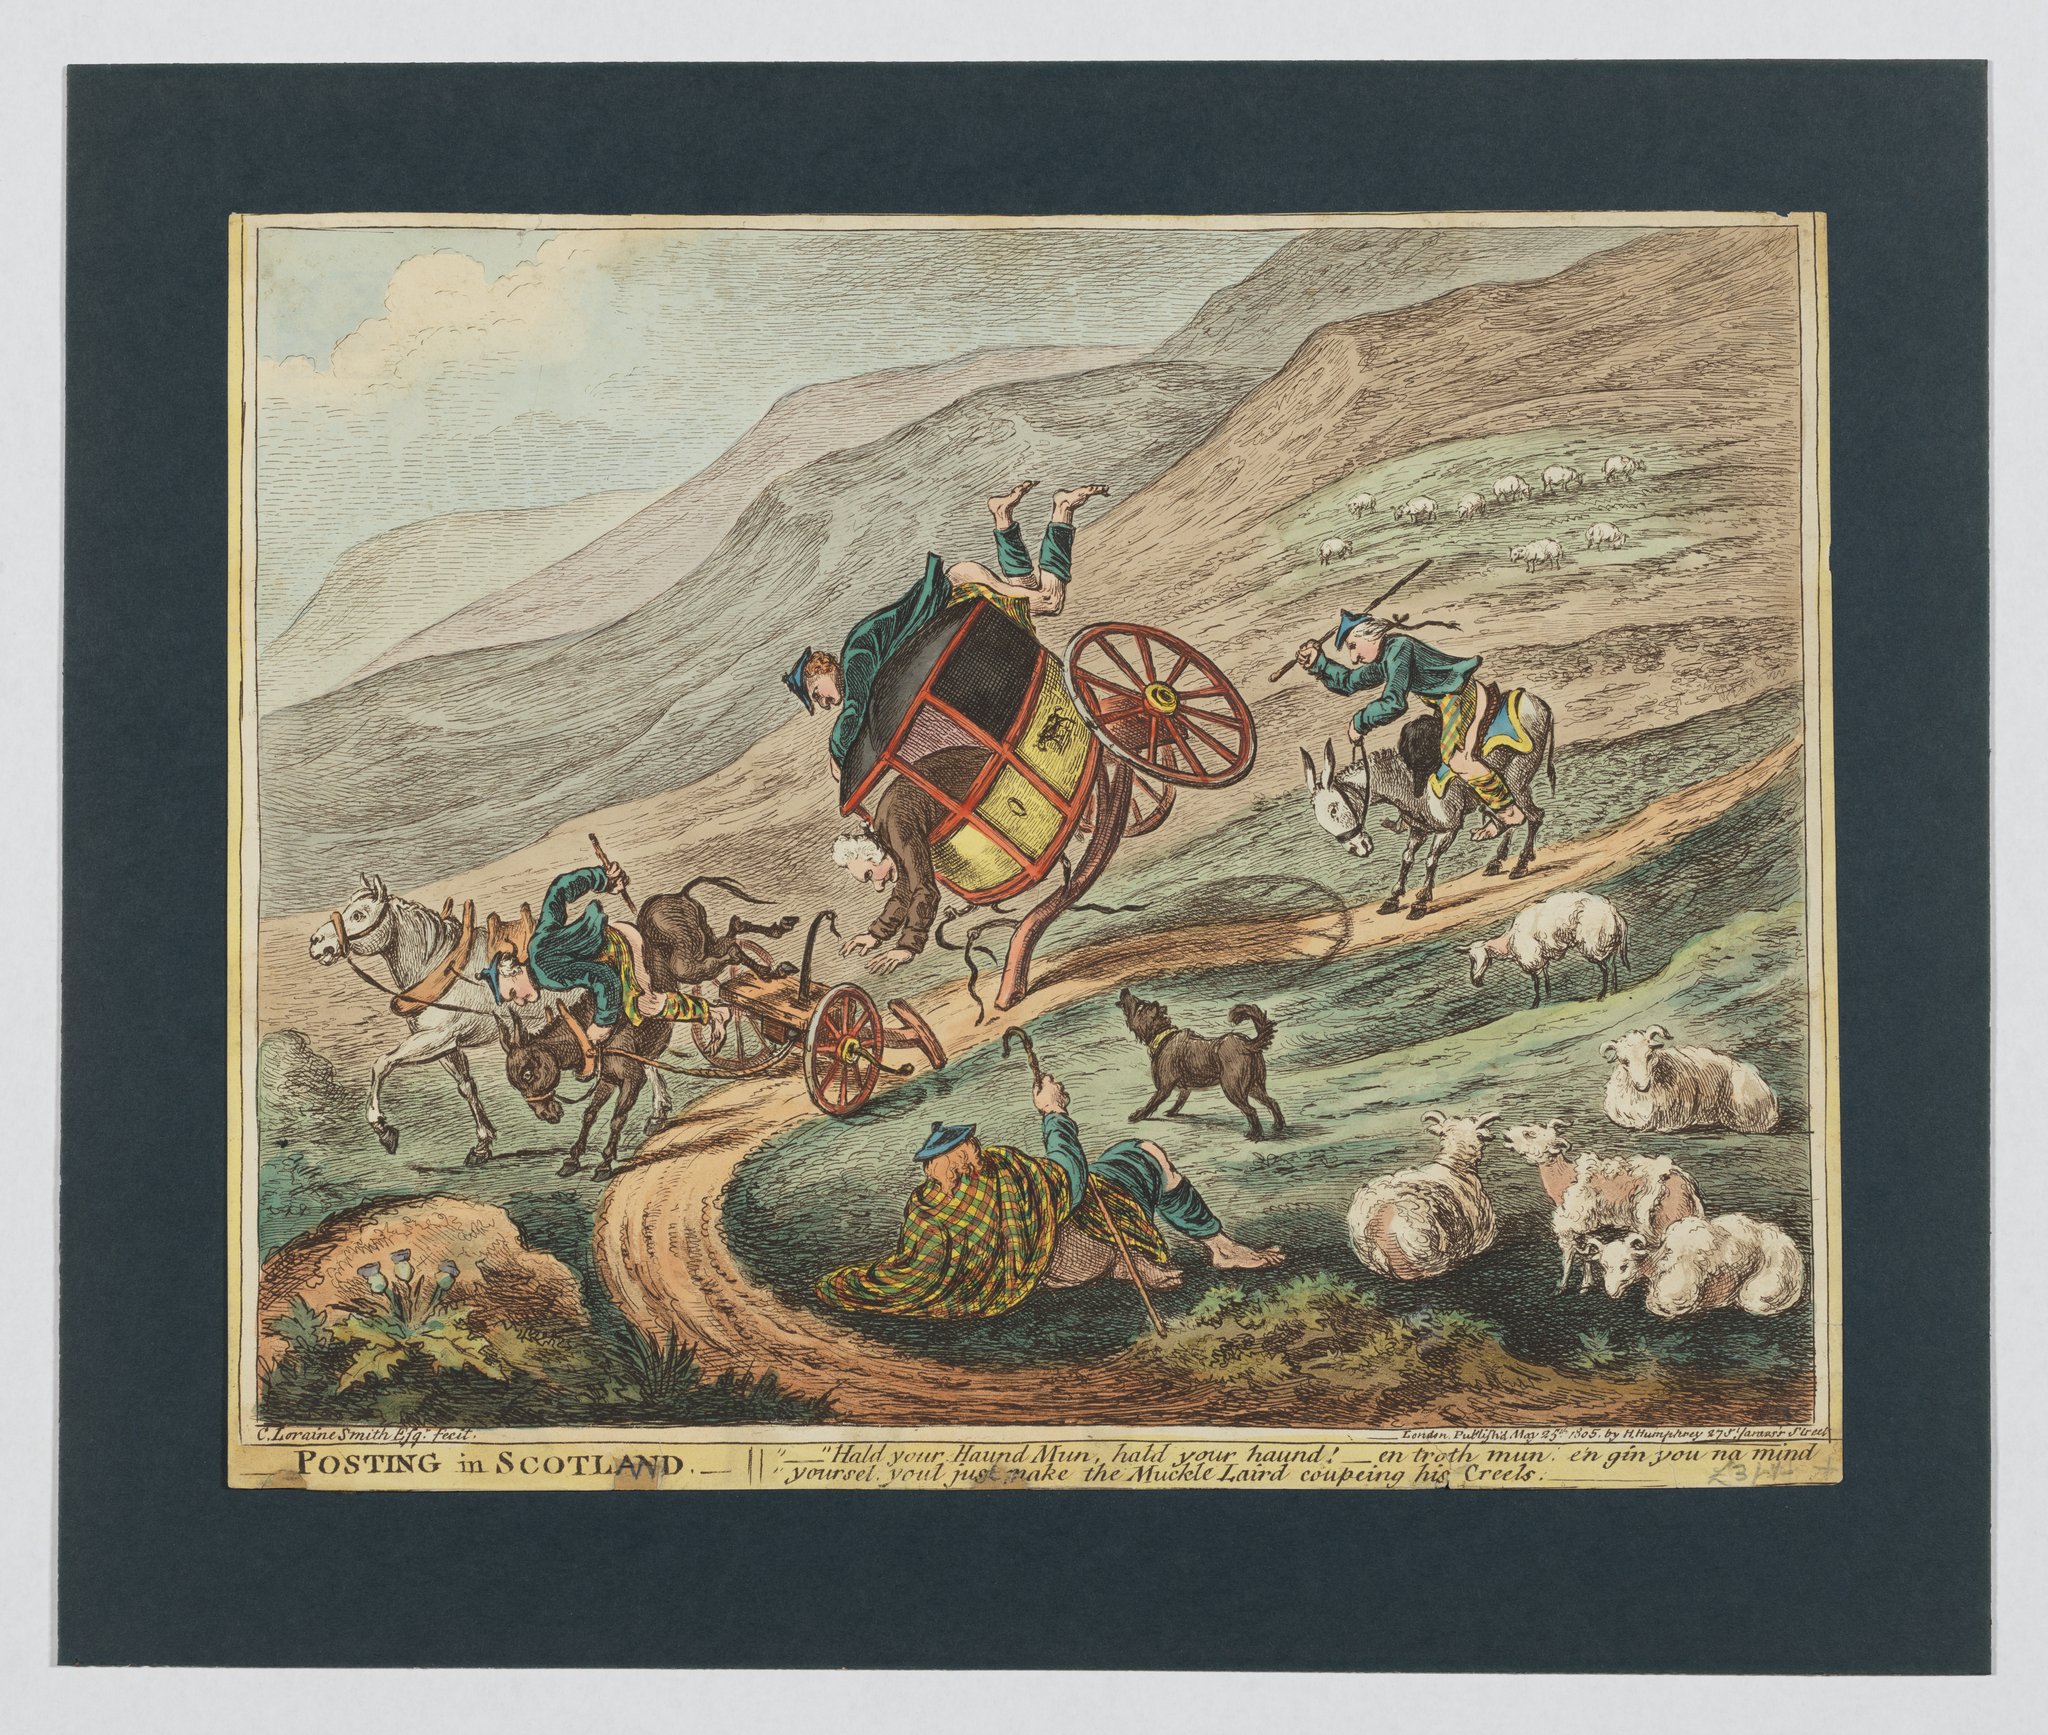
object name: print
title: Posting in Scotland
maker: james gillray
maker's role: artist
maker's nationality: british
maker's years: 1756-1815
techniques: aquatint, etching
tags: satire,dogs,horses,sheep,carriages